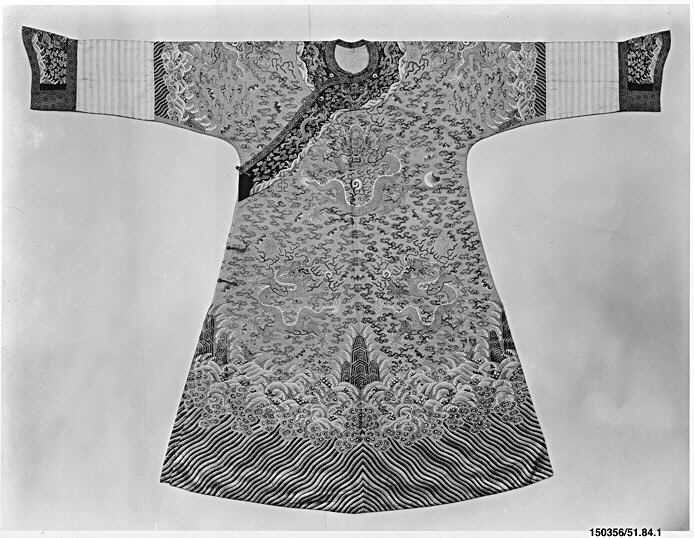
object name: robe, emperor's 12 symbol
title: Emperor's Twelve-Symbol Robe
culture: chinese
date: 1736-1795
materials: silk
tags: dragons